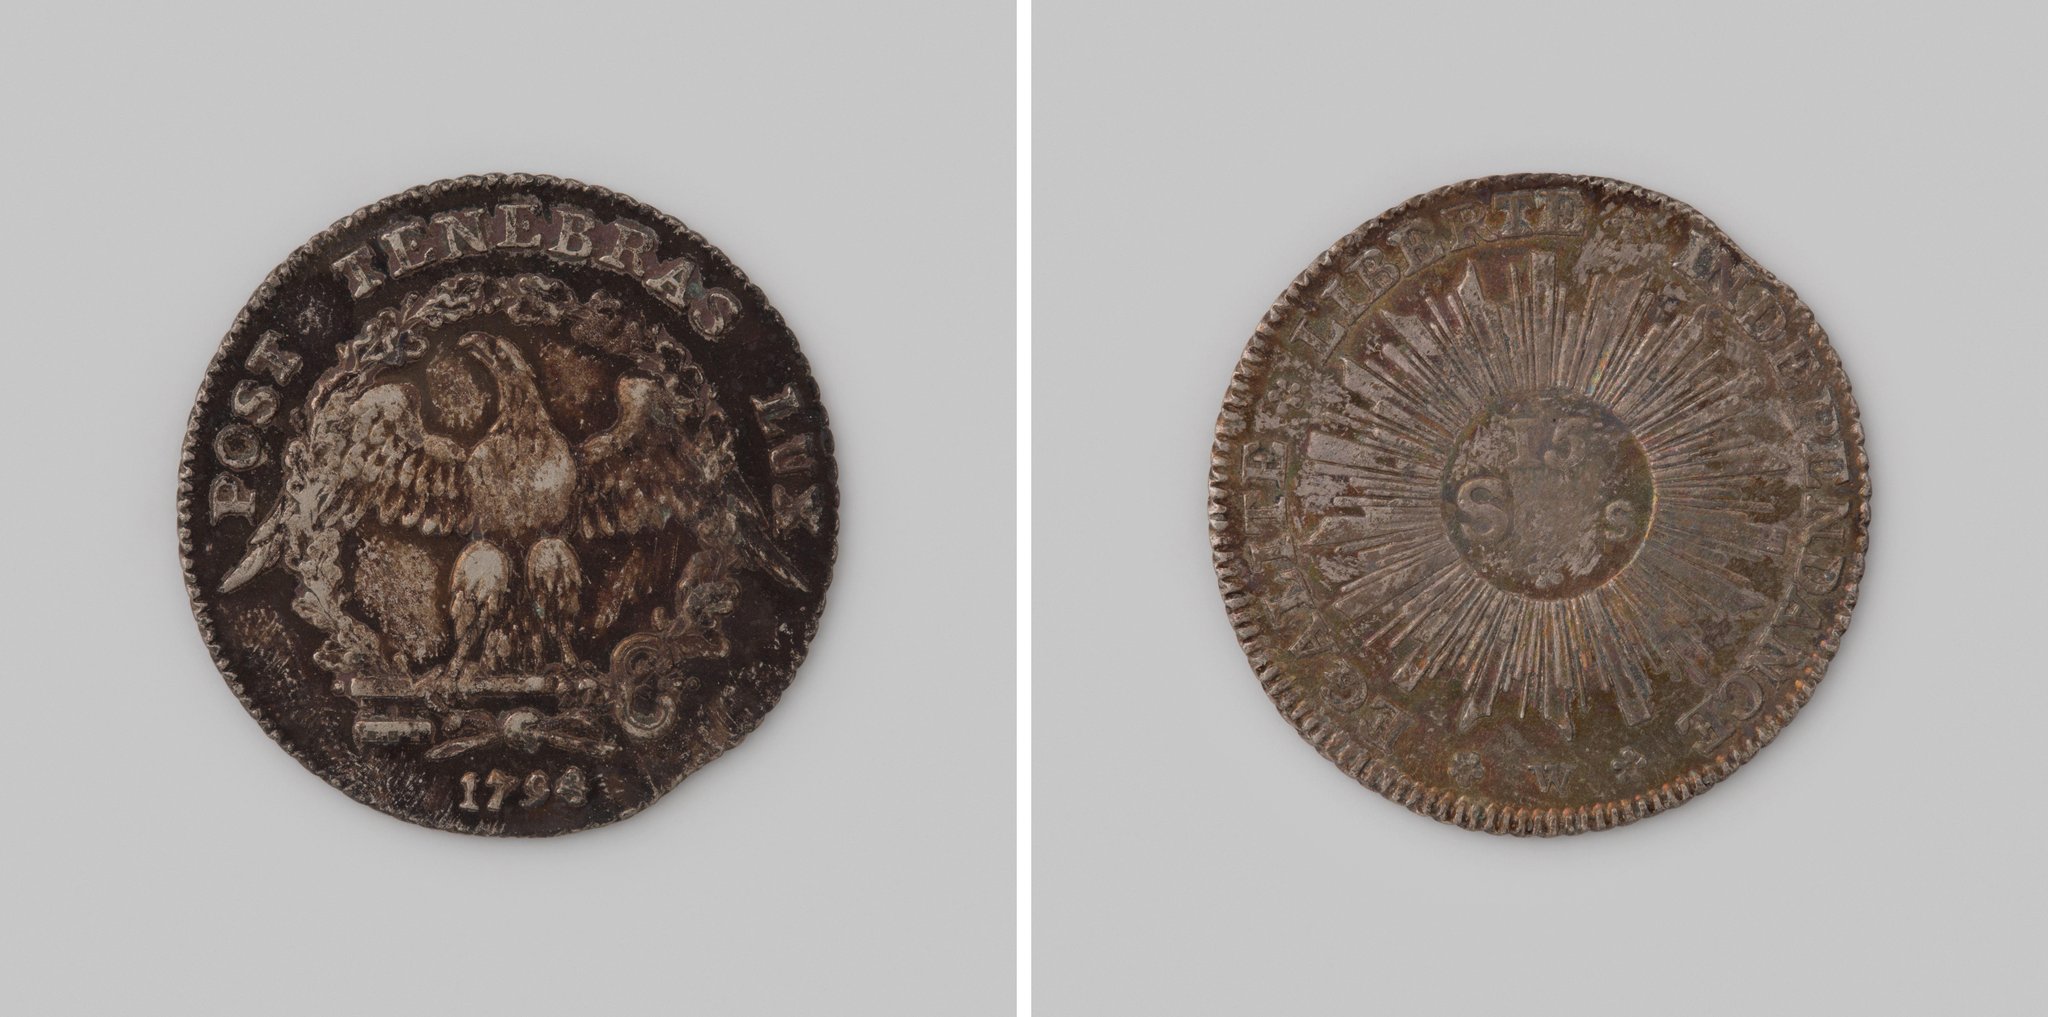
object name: coin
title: 15 sols uit de stad Geneve, 1794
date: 1794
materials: silver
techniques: striking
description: Zilveren munt. Voorzijde: op sleutel staande adelaar met gespreide vleugels, waarvóór twee samengebonden takken. Jaartal onderaan in omschrift. Keerzijde: binnen stralende zon waarde-aanduiding in twee regels. Kabelrand.